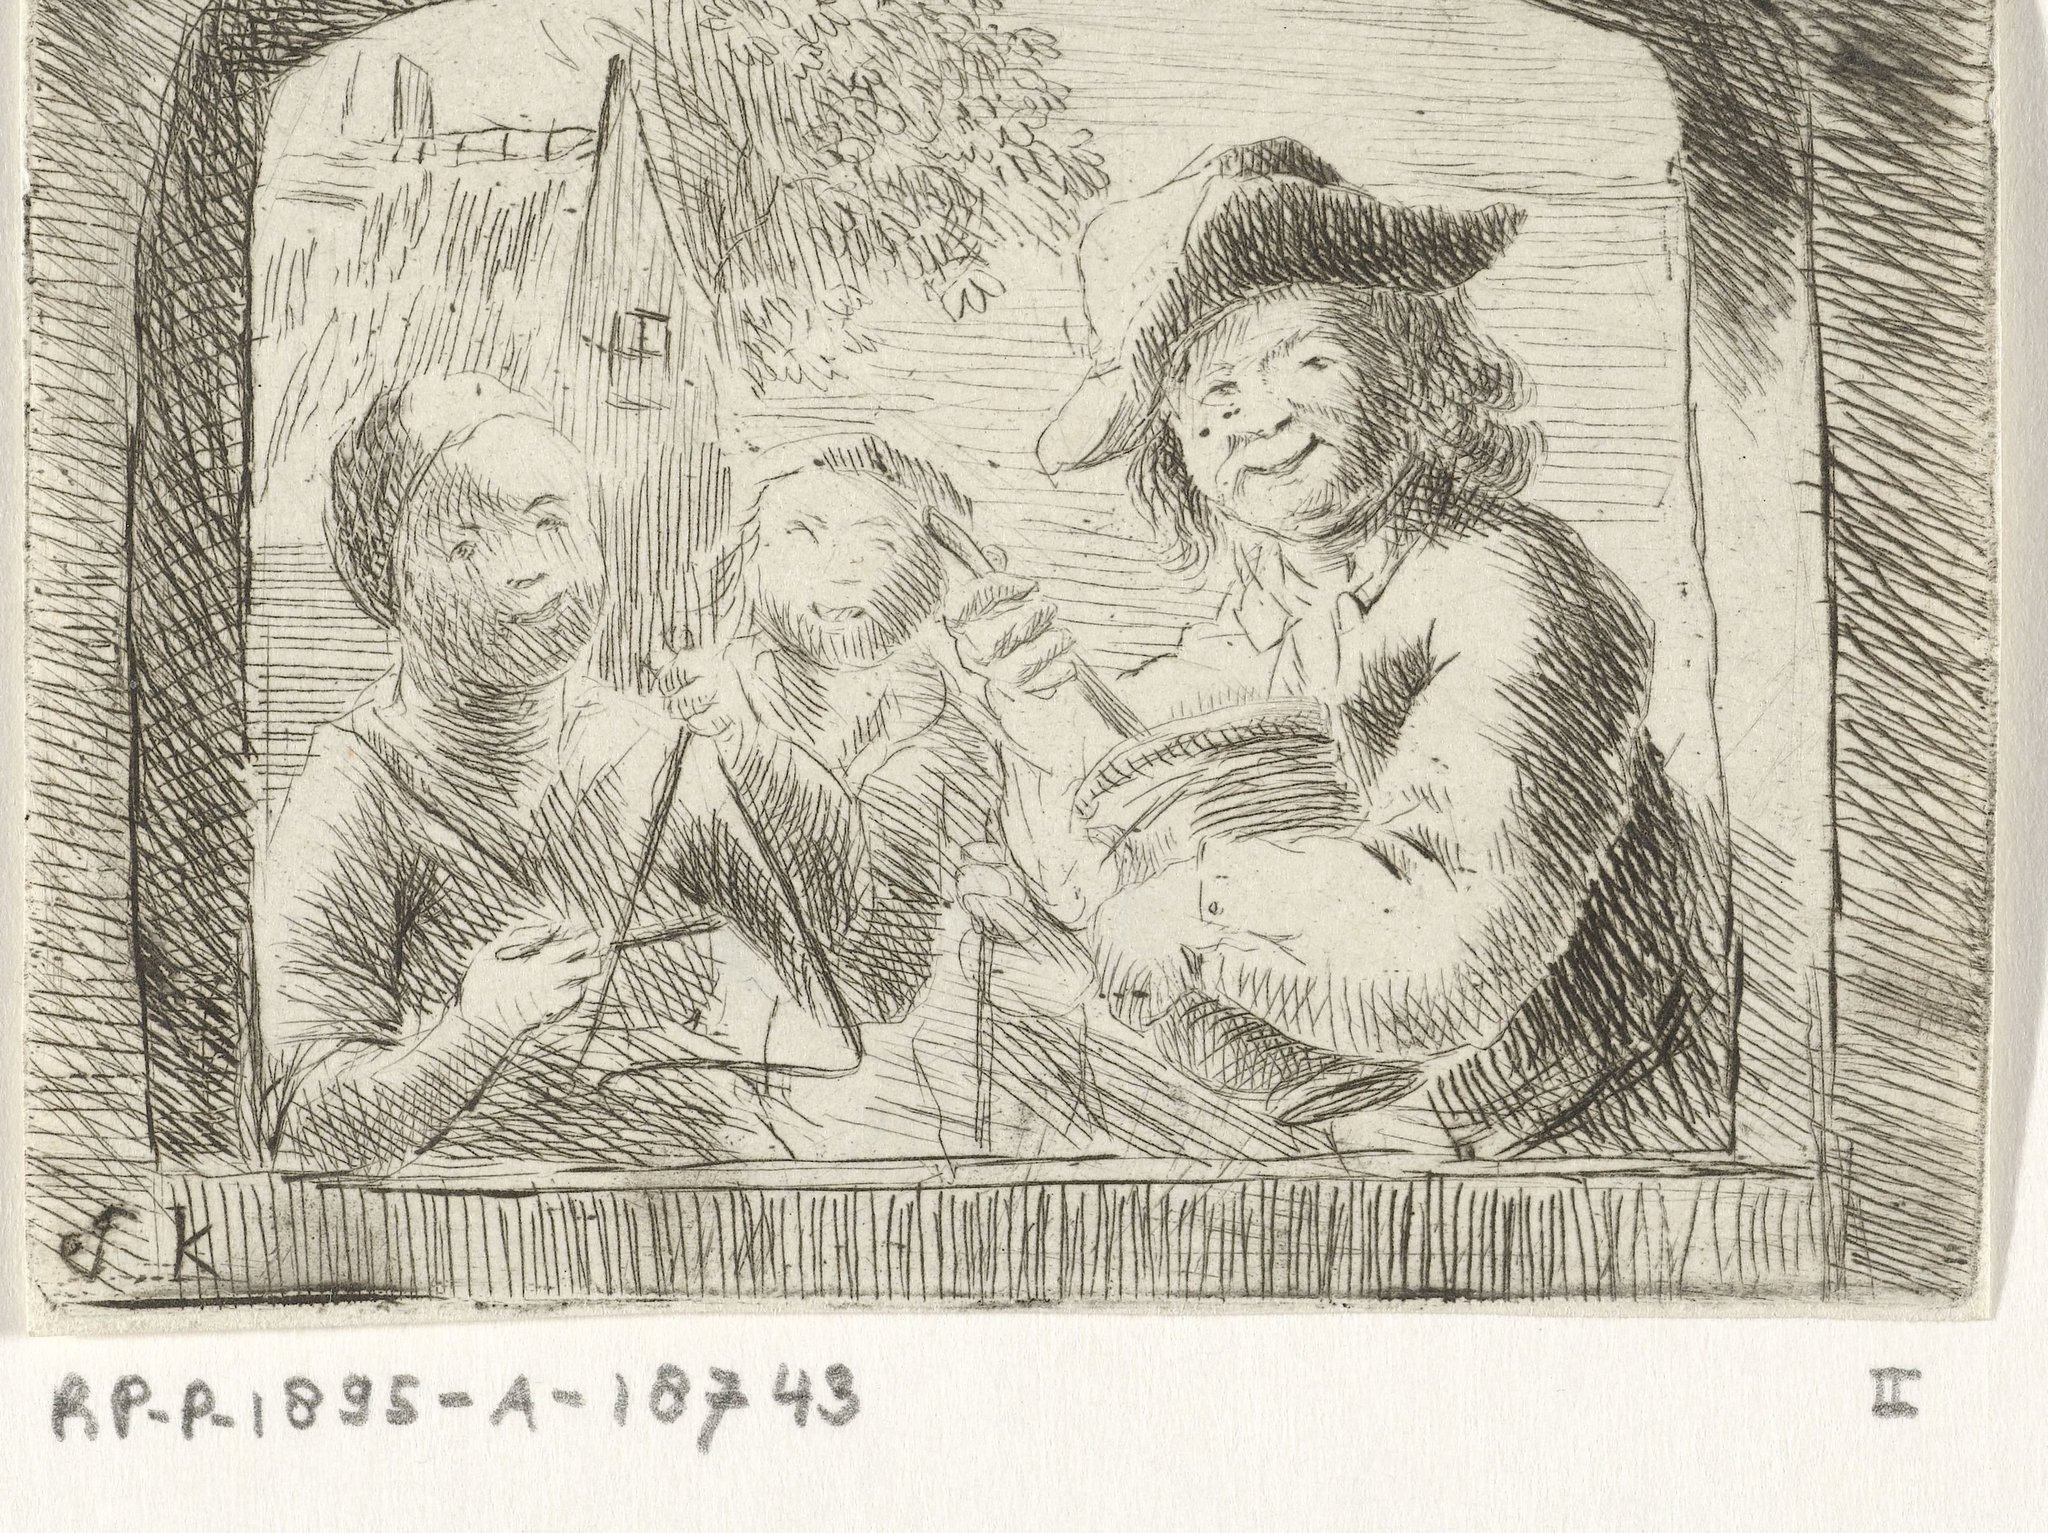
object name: print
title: Rommelpotspeler en twee kinderen in een nis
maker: simon klapmuts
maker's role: print maker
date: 1744-1780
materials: paper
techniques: etching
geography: moordrecht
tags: improvised musical instruments: rumbling pot, other percussion instruments (with name)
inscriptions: collector's mark: Lugt 2228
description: In een nis staan een jongen met een rommelpot, een meisje met een triangel en een tweede meisje.